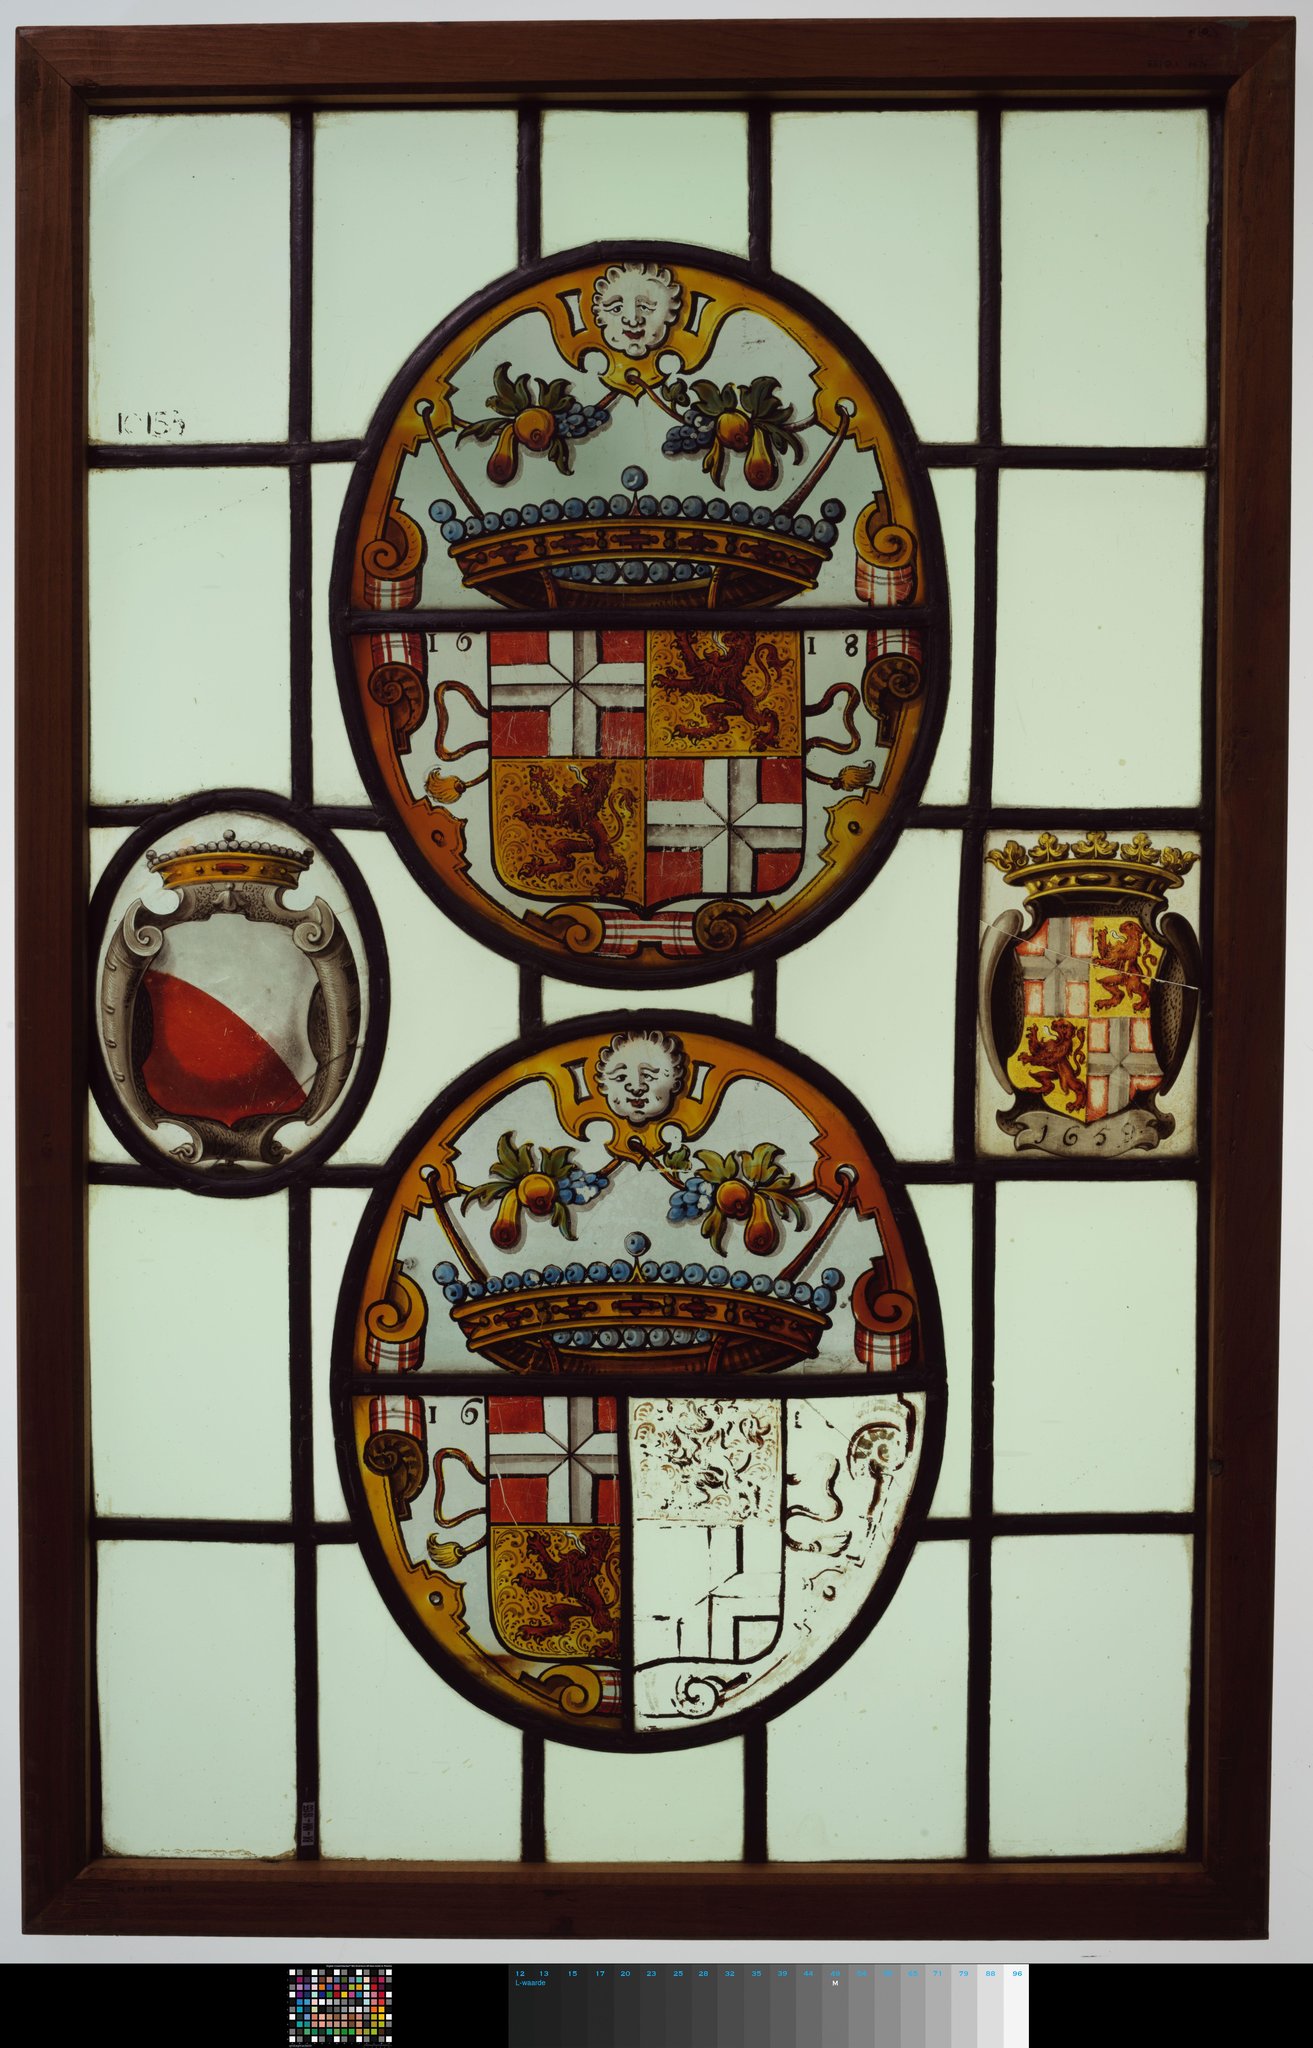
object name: light window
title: Ruit met vier wapens, waaronder het wapen van Utrecht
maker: Anonymous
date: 1618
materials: glass, lead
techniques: leading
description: Vier gekleurde ovale ruiten van gebrandschilderde glas met de wapens van Utrecht, waarvan twee grote en twee kleine ruiten.